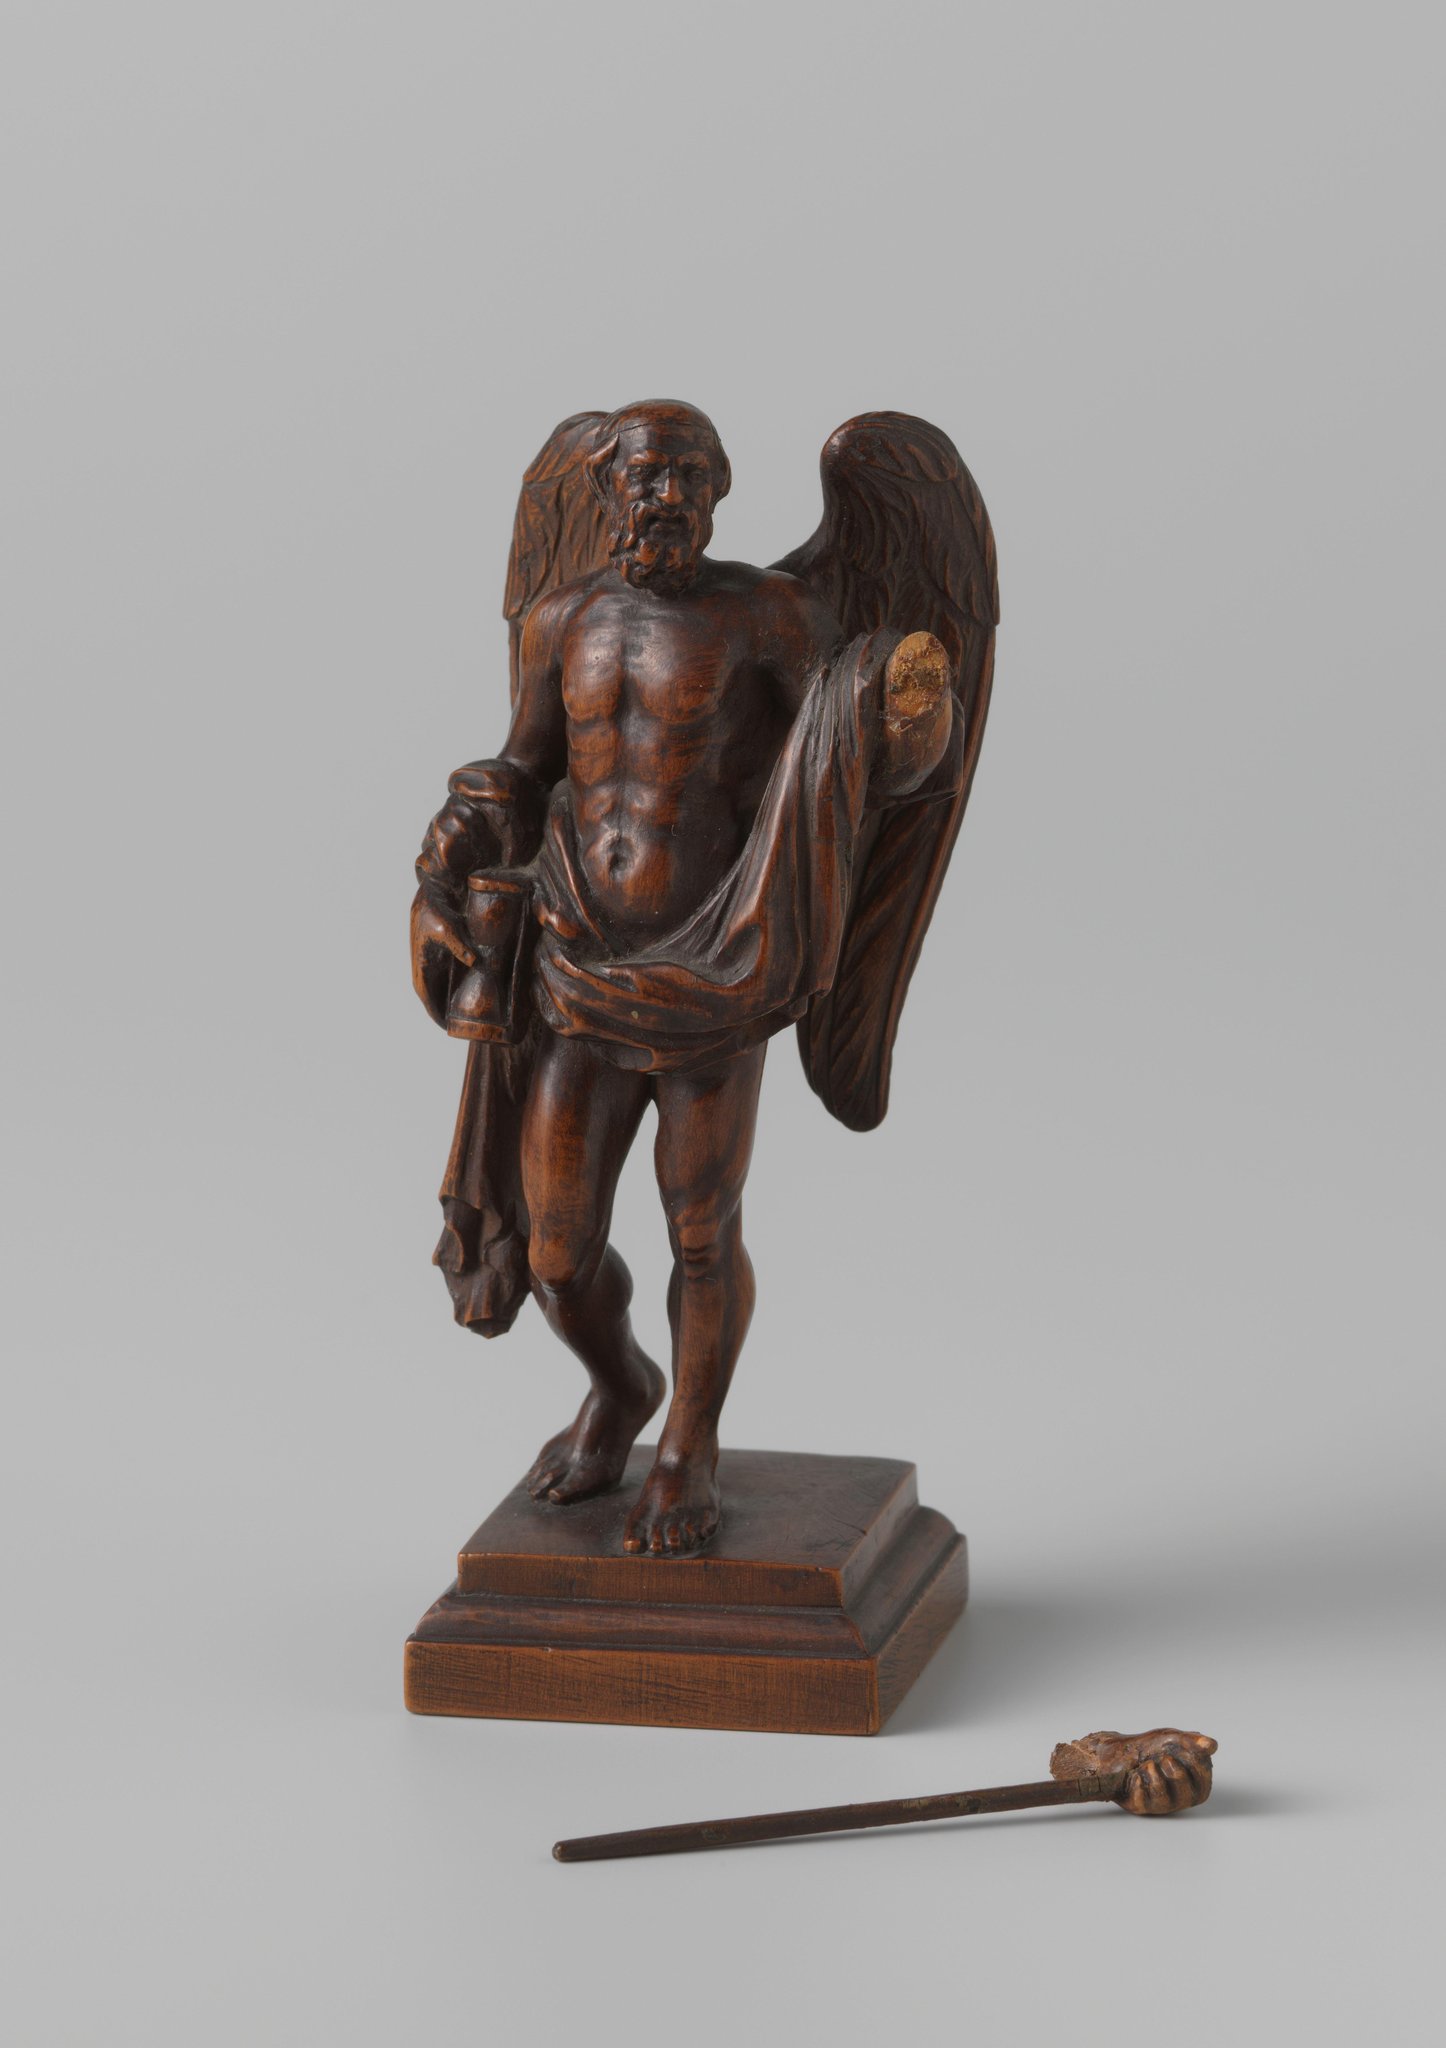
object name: figure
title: De Tijd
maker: Anonymous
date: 1600-1700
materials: wood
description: Figuur van palmhout, gevleugeld met zandloper. De zeis ontbreekt.